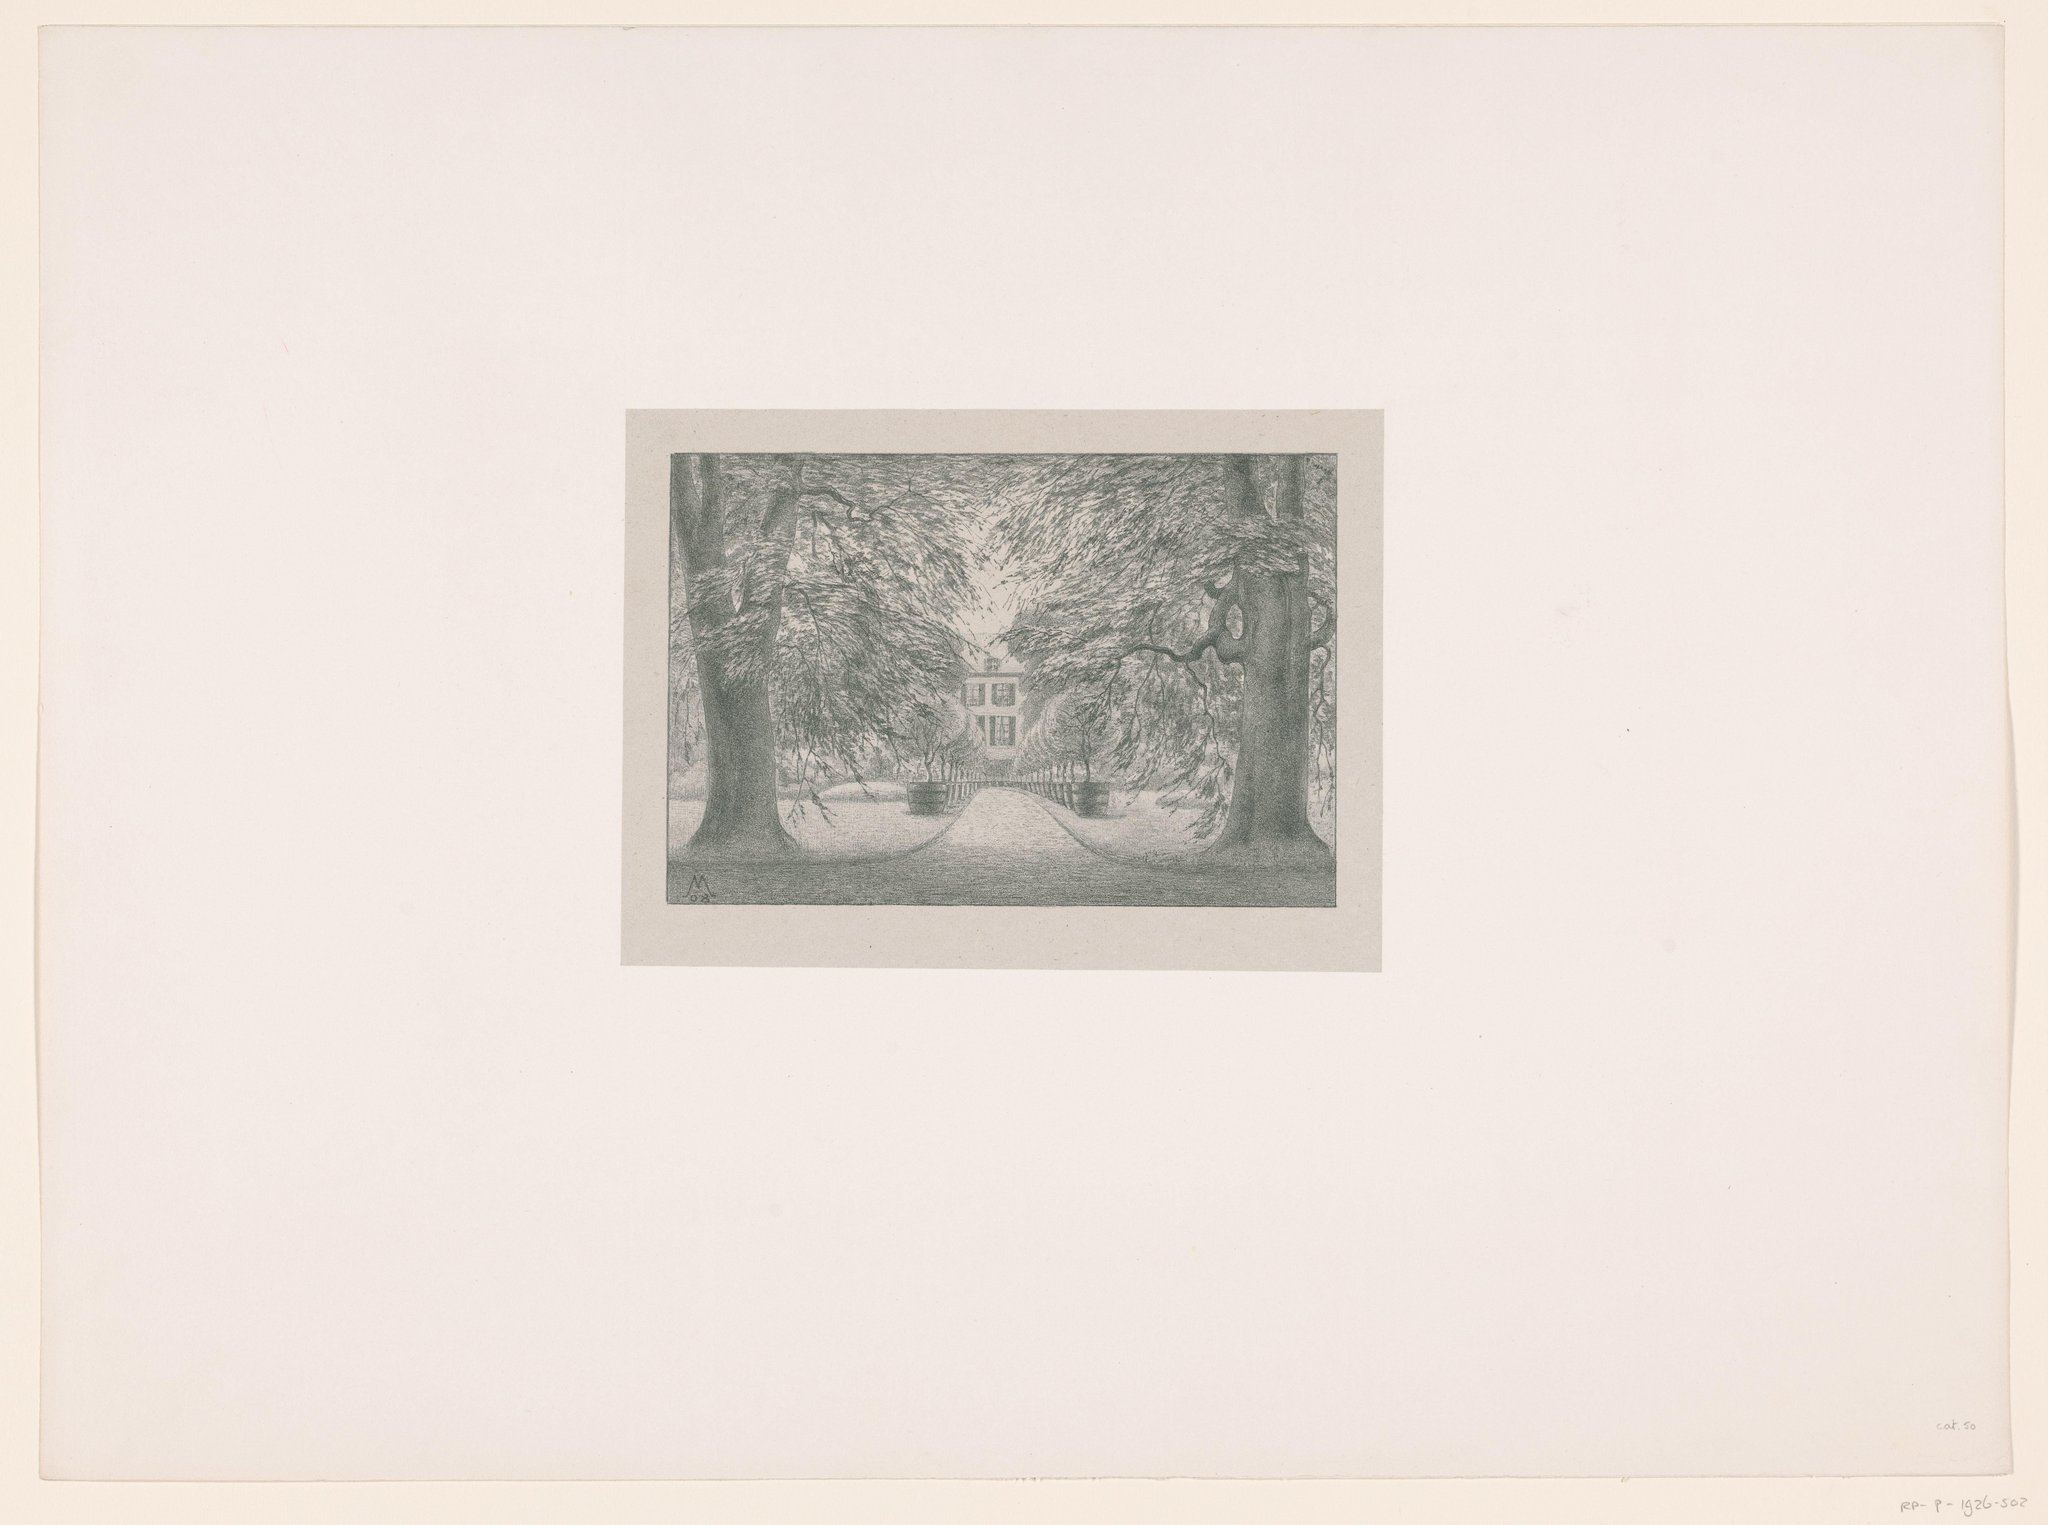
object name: print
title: Het Koninklijk park het Loo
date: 1908-1909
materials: paper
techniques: lithograph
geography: amsterdam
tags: palace, potted plants